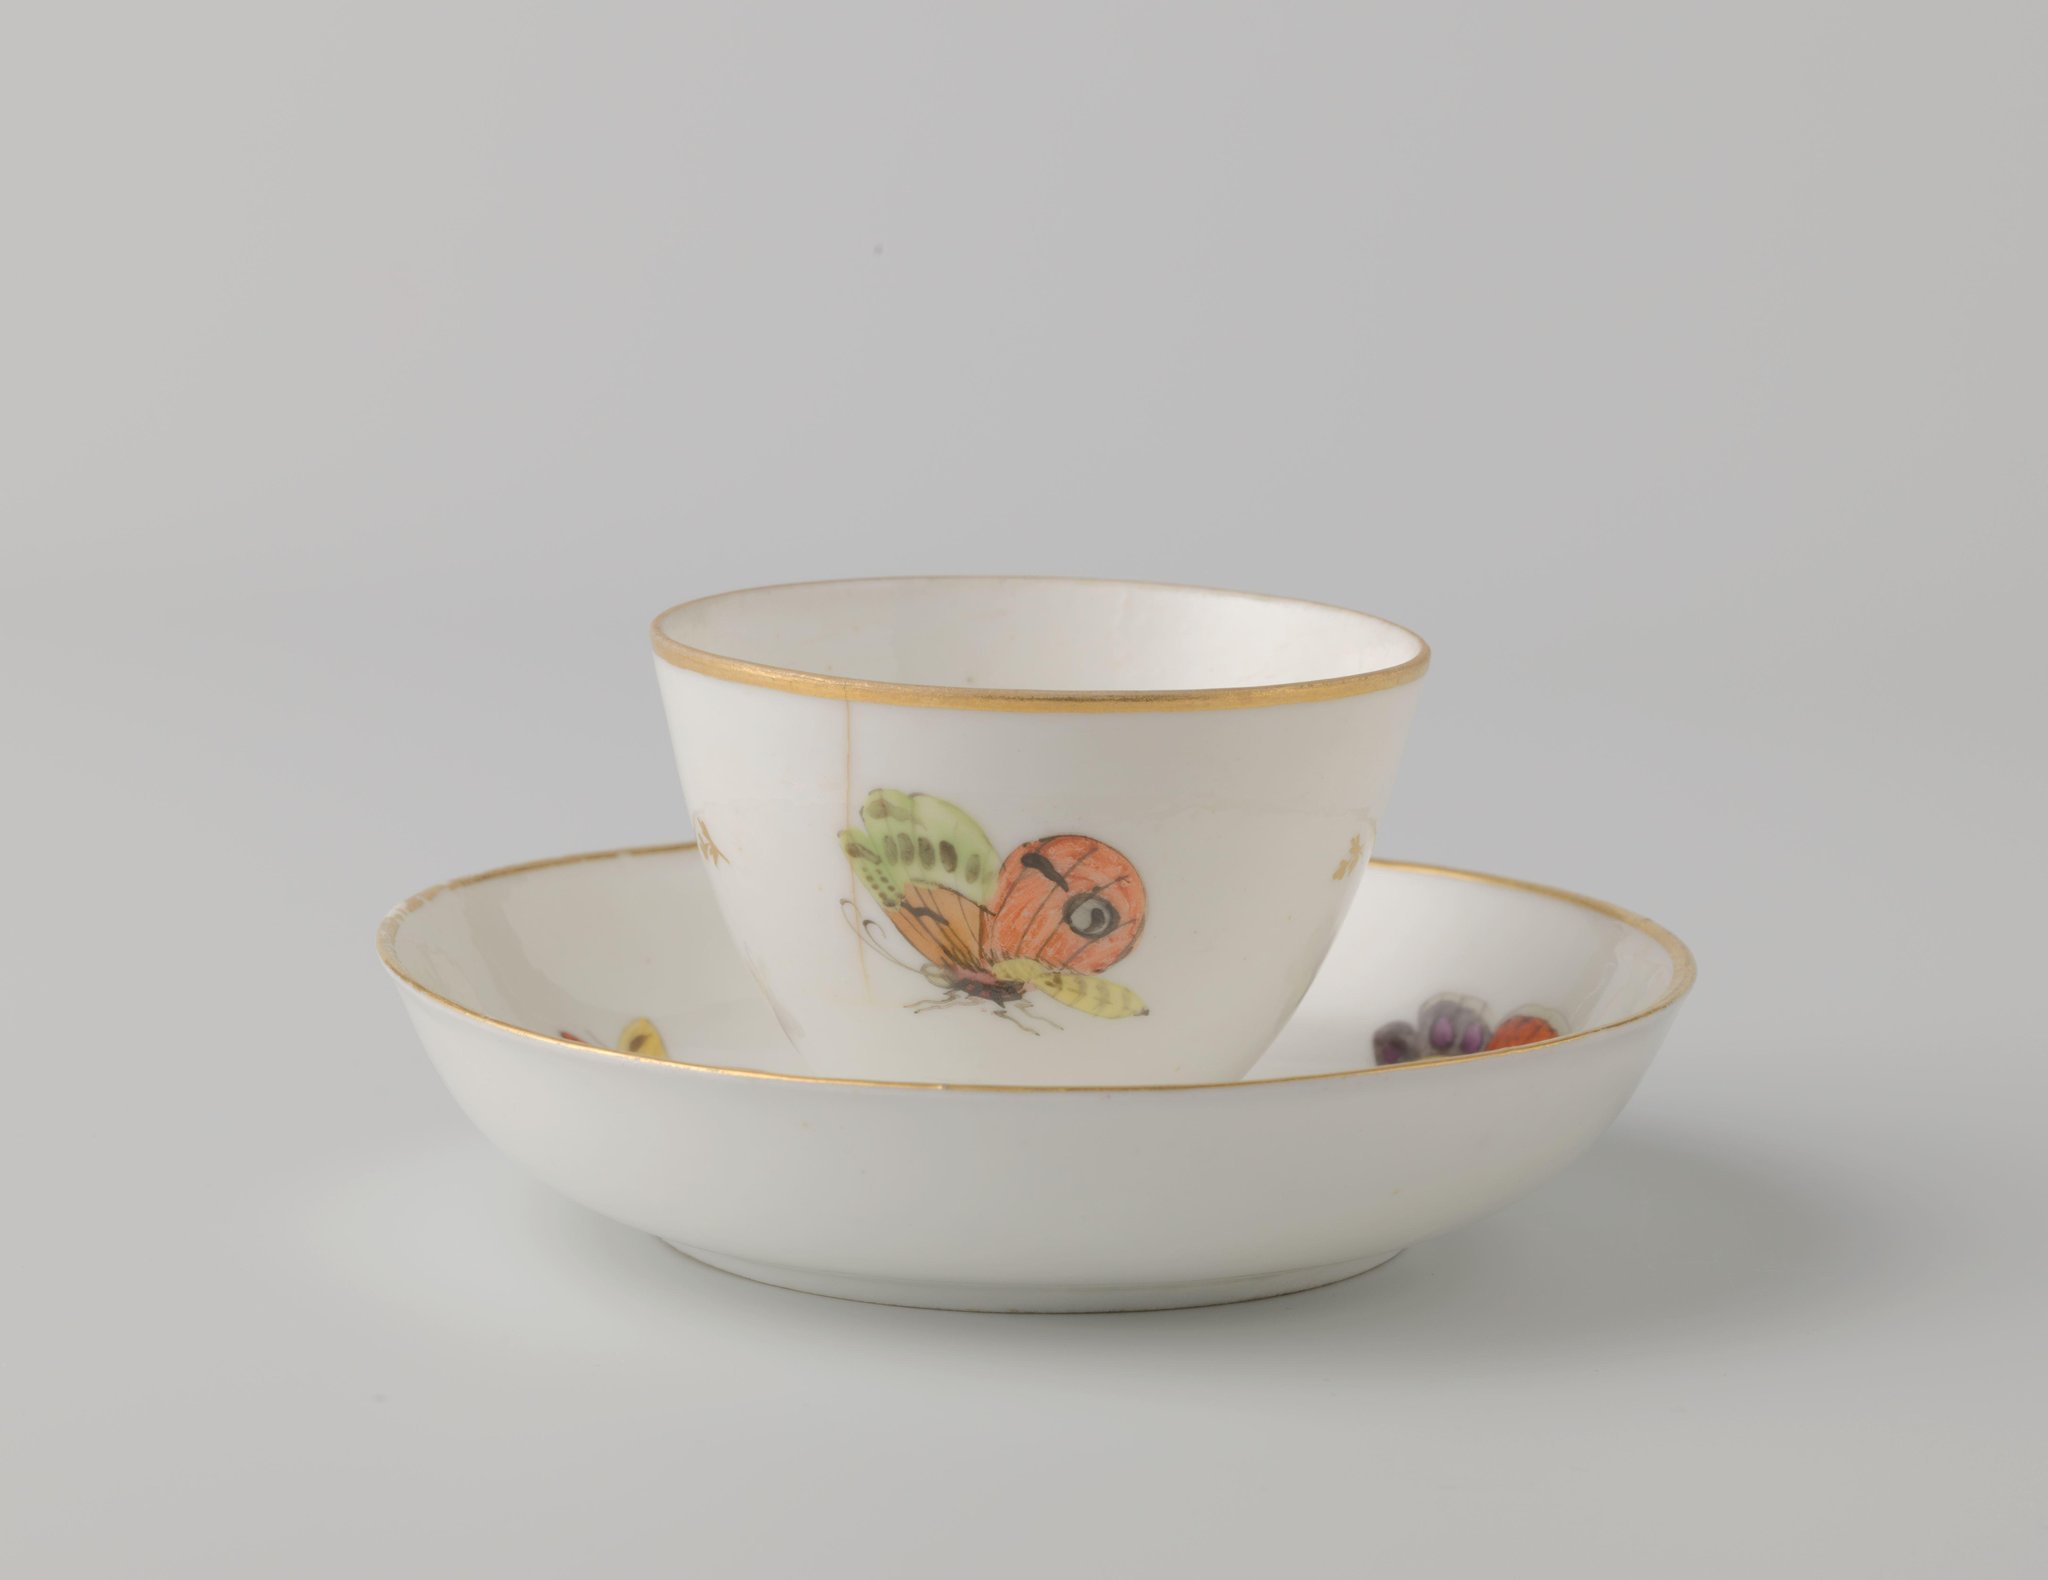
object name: cup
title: Kop beschilderd met vlinders en libellen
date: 1784-1809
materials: porcelain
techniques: painted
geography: ouder-amstel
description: Kop zonder oor en veelkleurig beschilderd met vlinders en libellen. Gemerkt: Amstel.